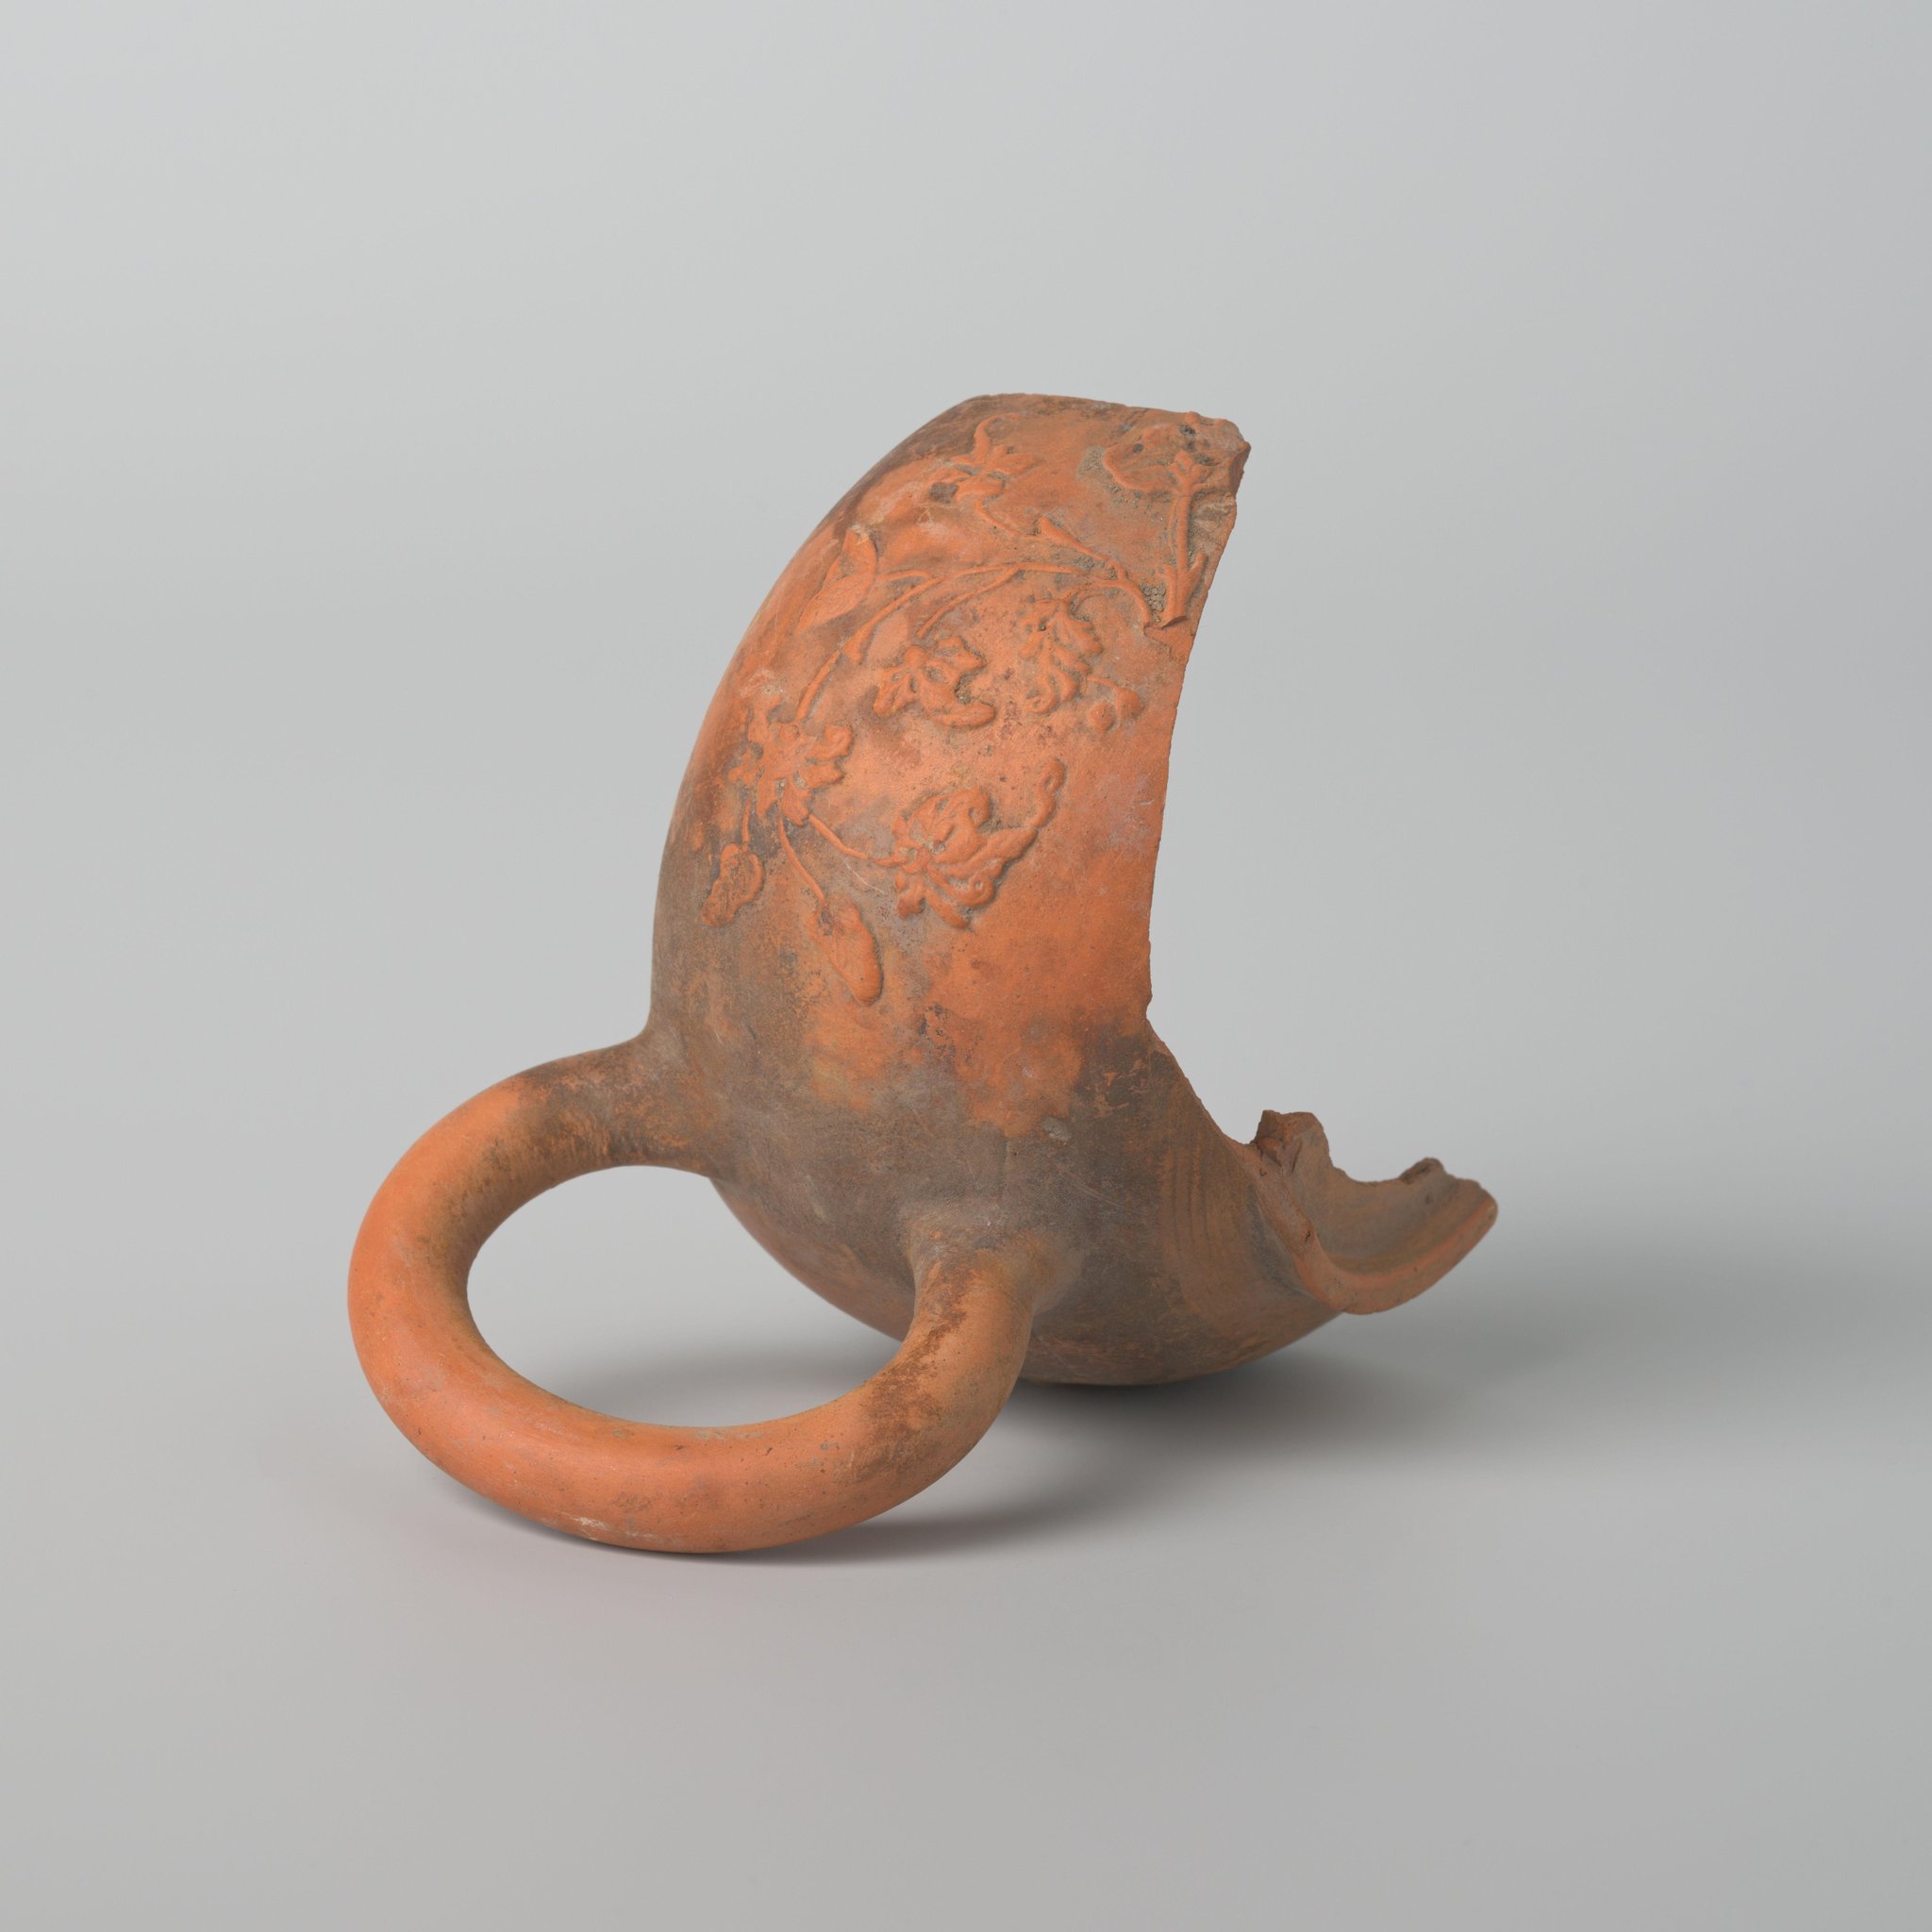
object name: teapot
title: Fragment van een theepot (De Caluwe bakafval)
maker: jacobus de caluwe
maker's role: plateelbakkerij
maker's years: -1730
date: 1700-1725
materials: earthenware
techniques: firing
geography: delft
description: Toegeschreven aan Jacobus de Caluwe, omdat dit voorwerp samen met gemerkte stukken (‘Jacobus De Caluwe’ en rennend hert) gevonden is op de plaats waar zich De Caluwes tweede werkplaats bevond. Er is een duidelijke stilistische overeenkomst tussen de gemerkte en niet gemerkte voorwerpen uit deze archeologische vondst.